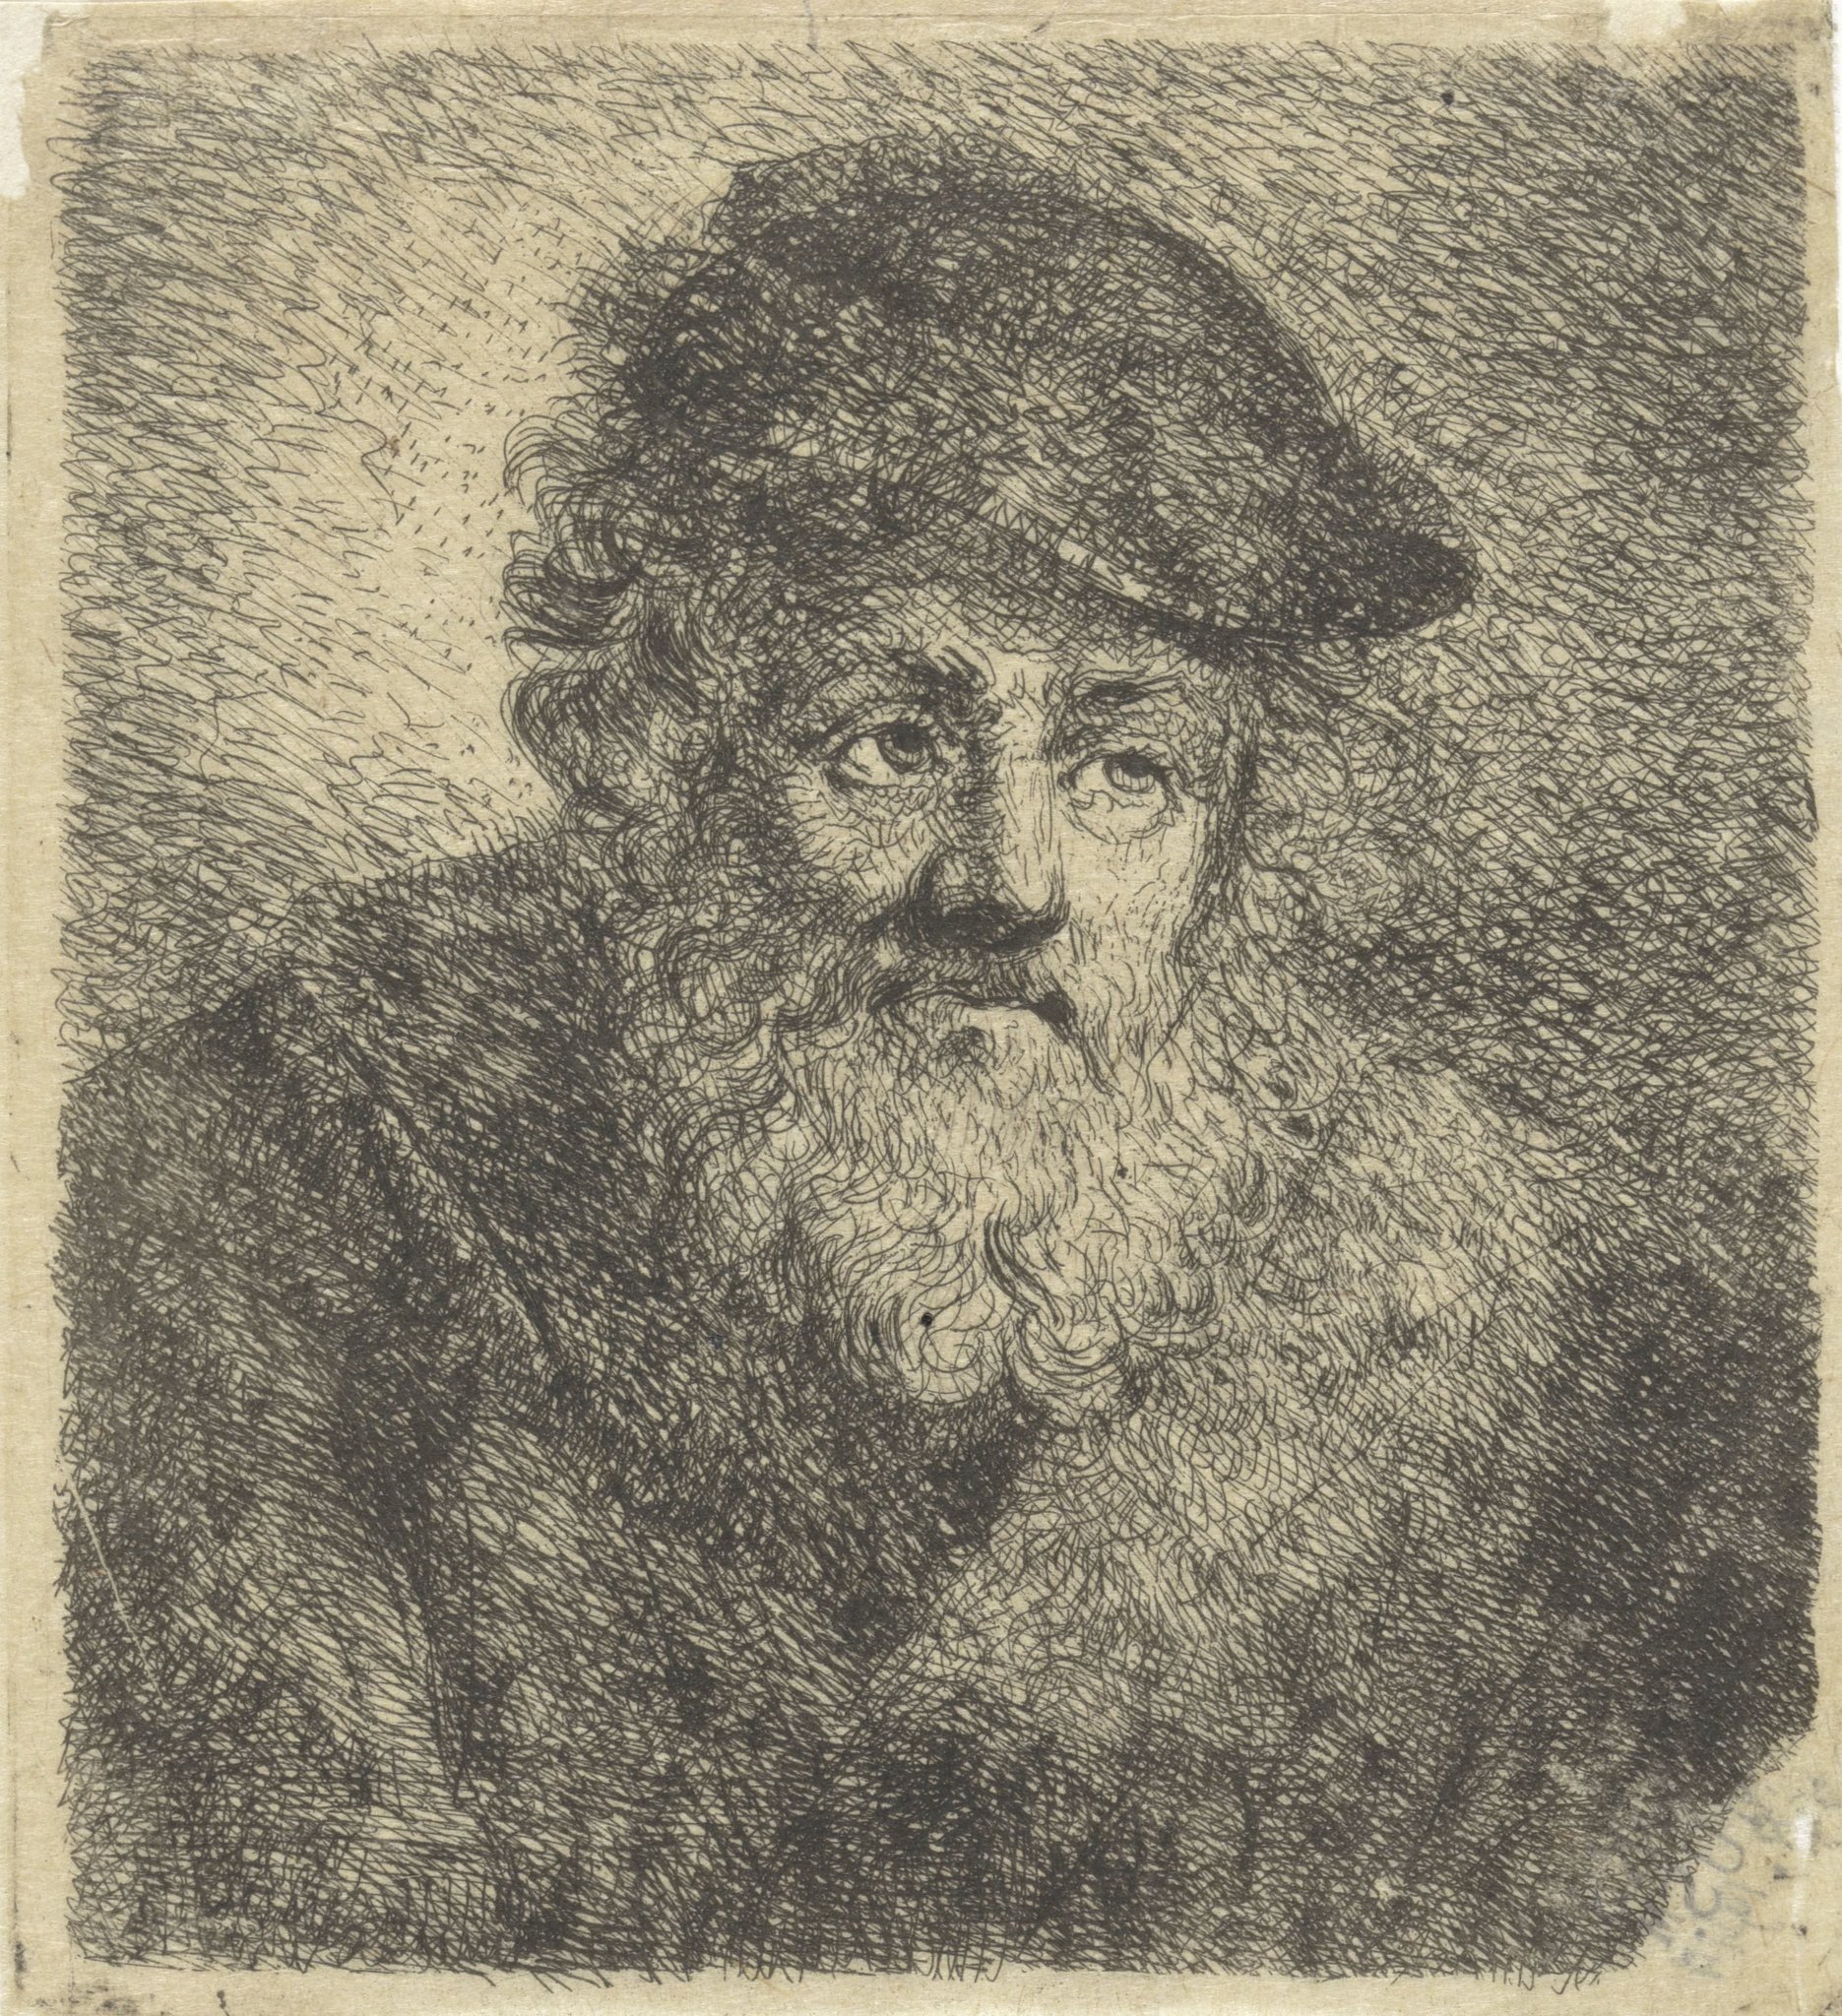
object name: print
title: Oude man met baard en muts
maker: cornelia scheffer-lamme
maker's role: print maker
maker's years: 1769-1839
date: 1784-1839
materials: paper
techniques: etching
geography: northern netherlands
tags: head-gear: cap (+ men's clothes), old man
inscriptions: collector's mark: Lugt 2166